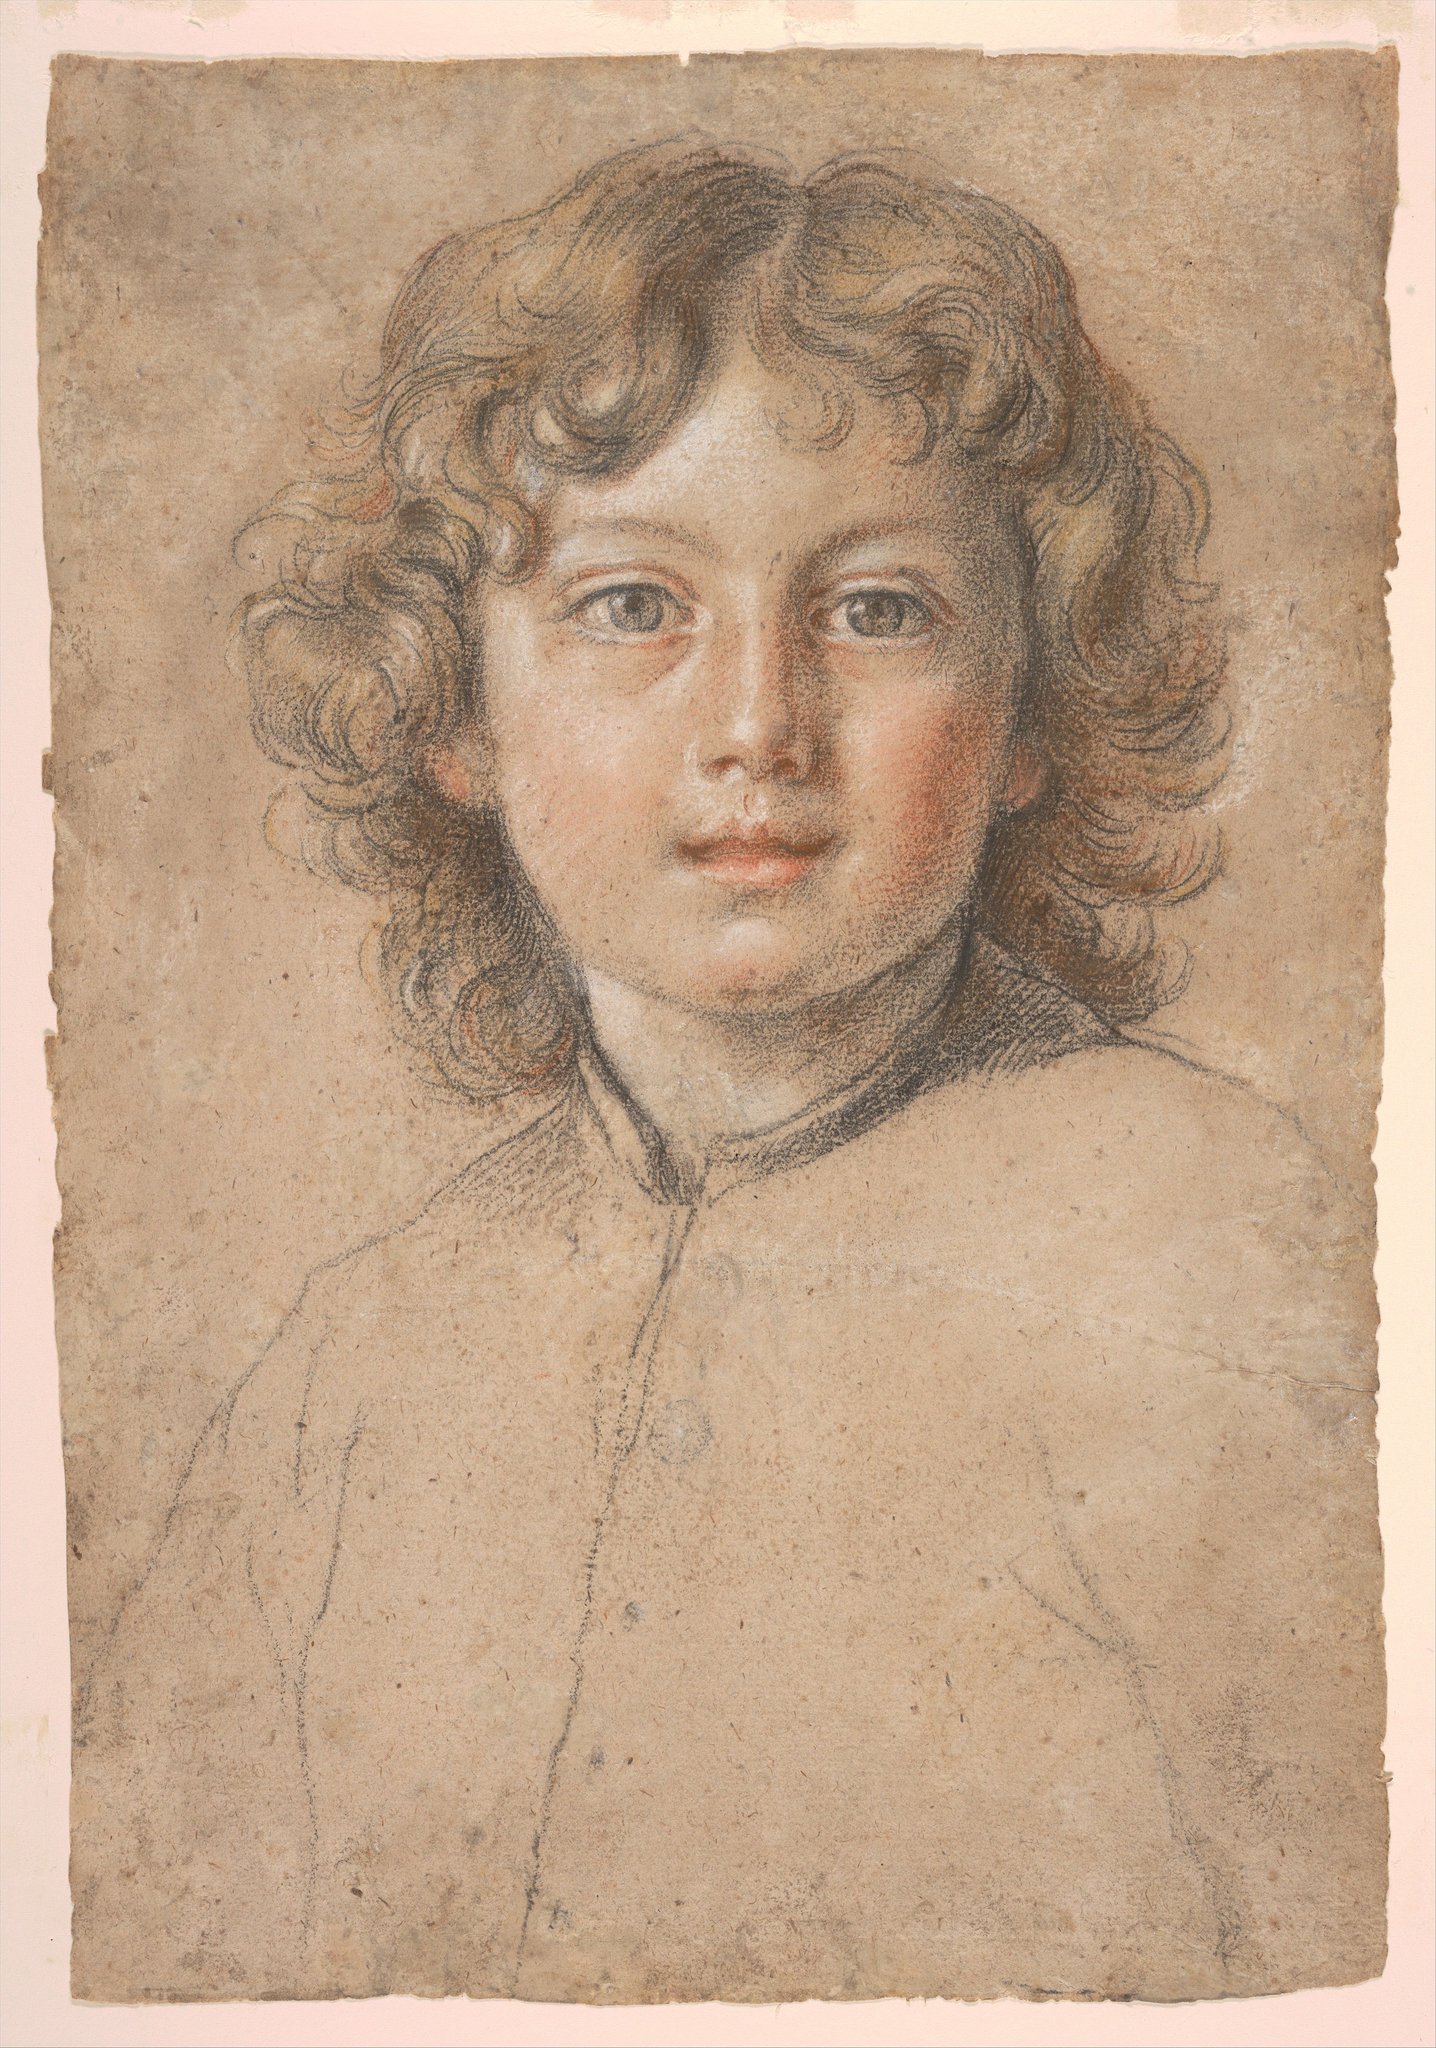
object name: drawing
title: Head of a Young Boy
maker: anonymous, italian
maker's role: artist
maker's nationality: italian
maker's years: 1400-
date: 1601-1700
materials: chalk, paper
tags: boys,portraits